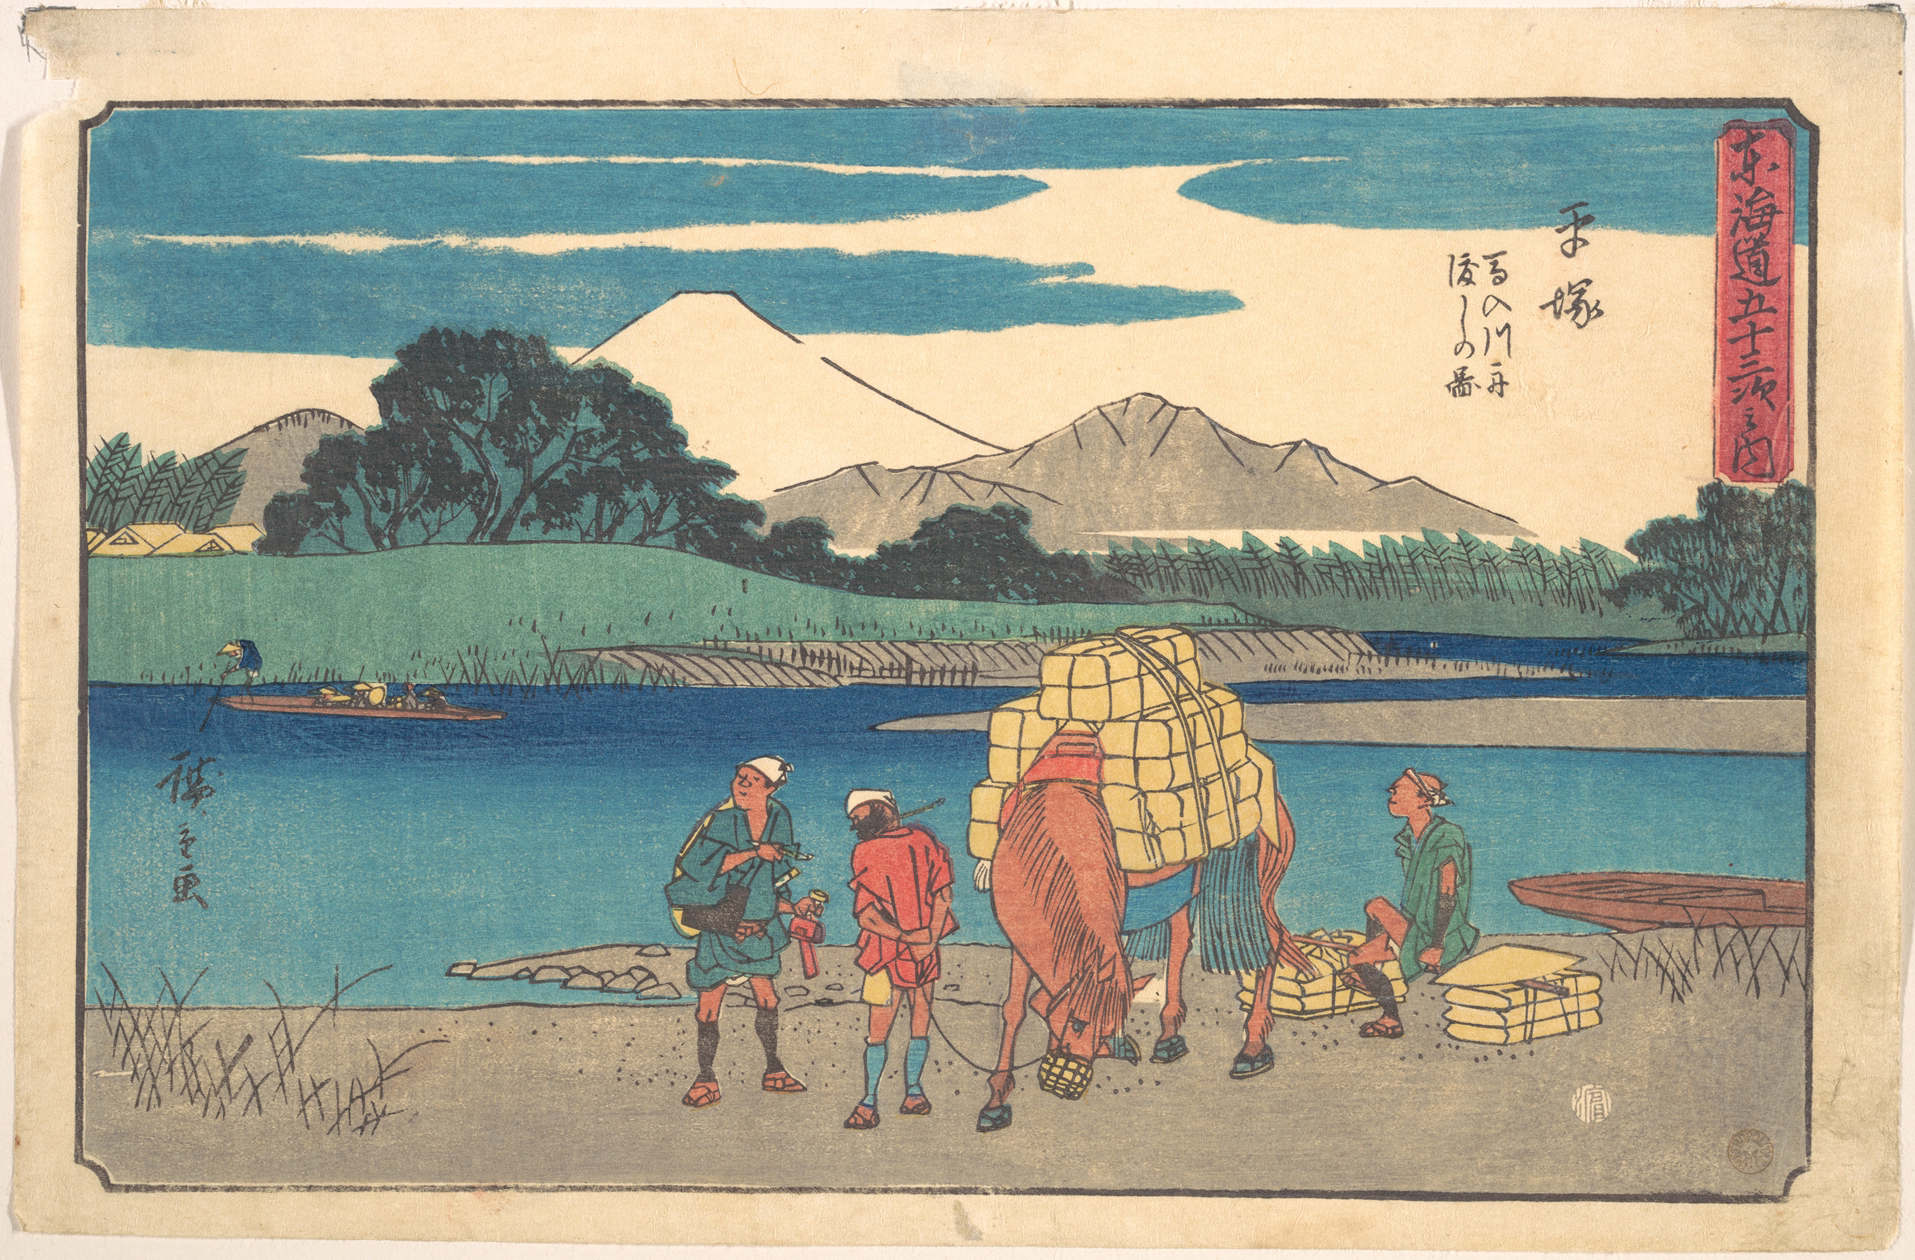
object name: print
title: Hiratsuka; Banyugawa Funa Watashi no Zu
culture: japanese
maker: utagawa hiroshige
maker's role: artist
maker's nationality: japanese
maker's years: 1797-1858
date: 1842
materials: ink, paper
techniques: woodblock print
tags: men,horses,rivers,mountains